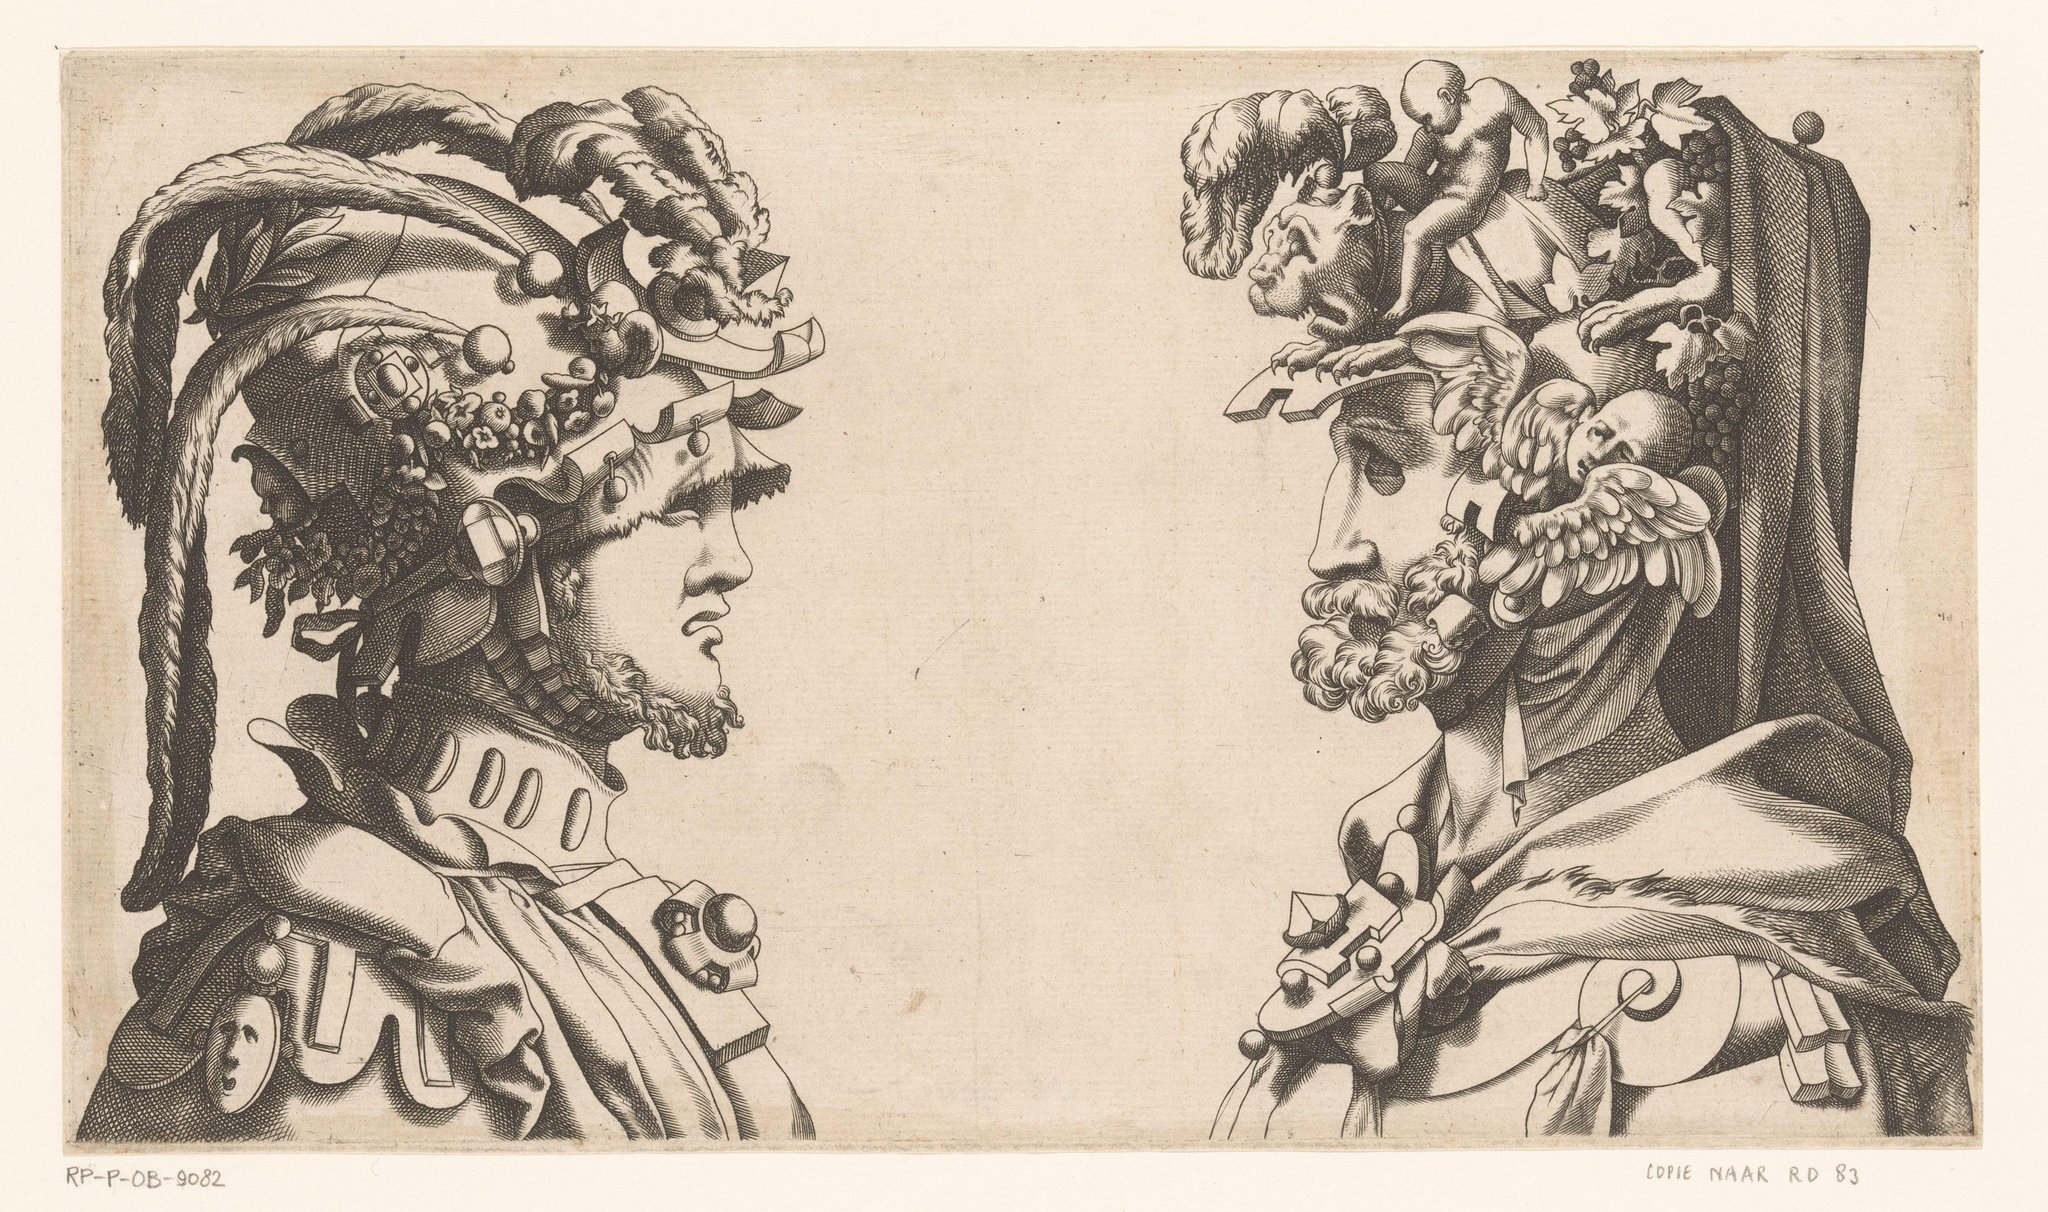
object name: print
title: Maskers en haardrachten voor het ballet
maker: Anonymous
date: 1535-1598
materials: paper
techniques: engraving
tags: mask, head-gear, the arts of the stage: ballet, theatre, musical drama, motion picture, fantasy costume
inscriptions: collector's mark: Lugt 240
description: Kopie naar een prent uit een serie van twaalf prenten met mannen- en vrouwenkostuums en haardrachten voor het ballet, getiteld 'Coiffures ou masques d'hommes et de femmes pour des ballets', naar ontwerp door Rosso Fiorentino.